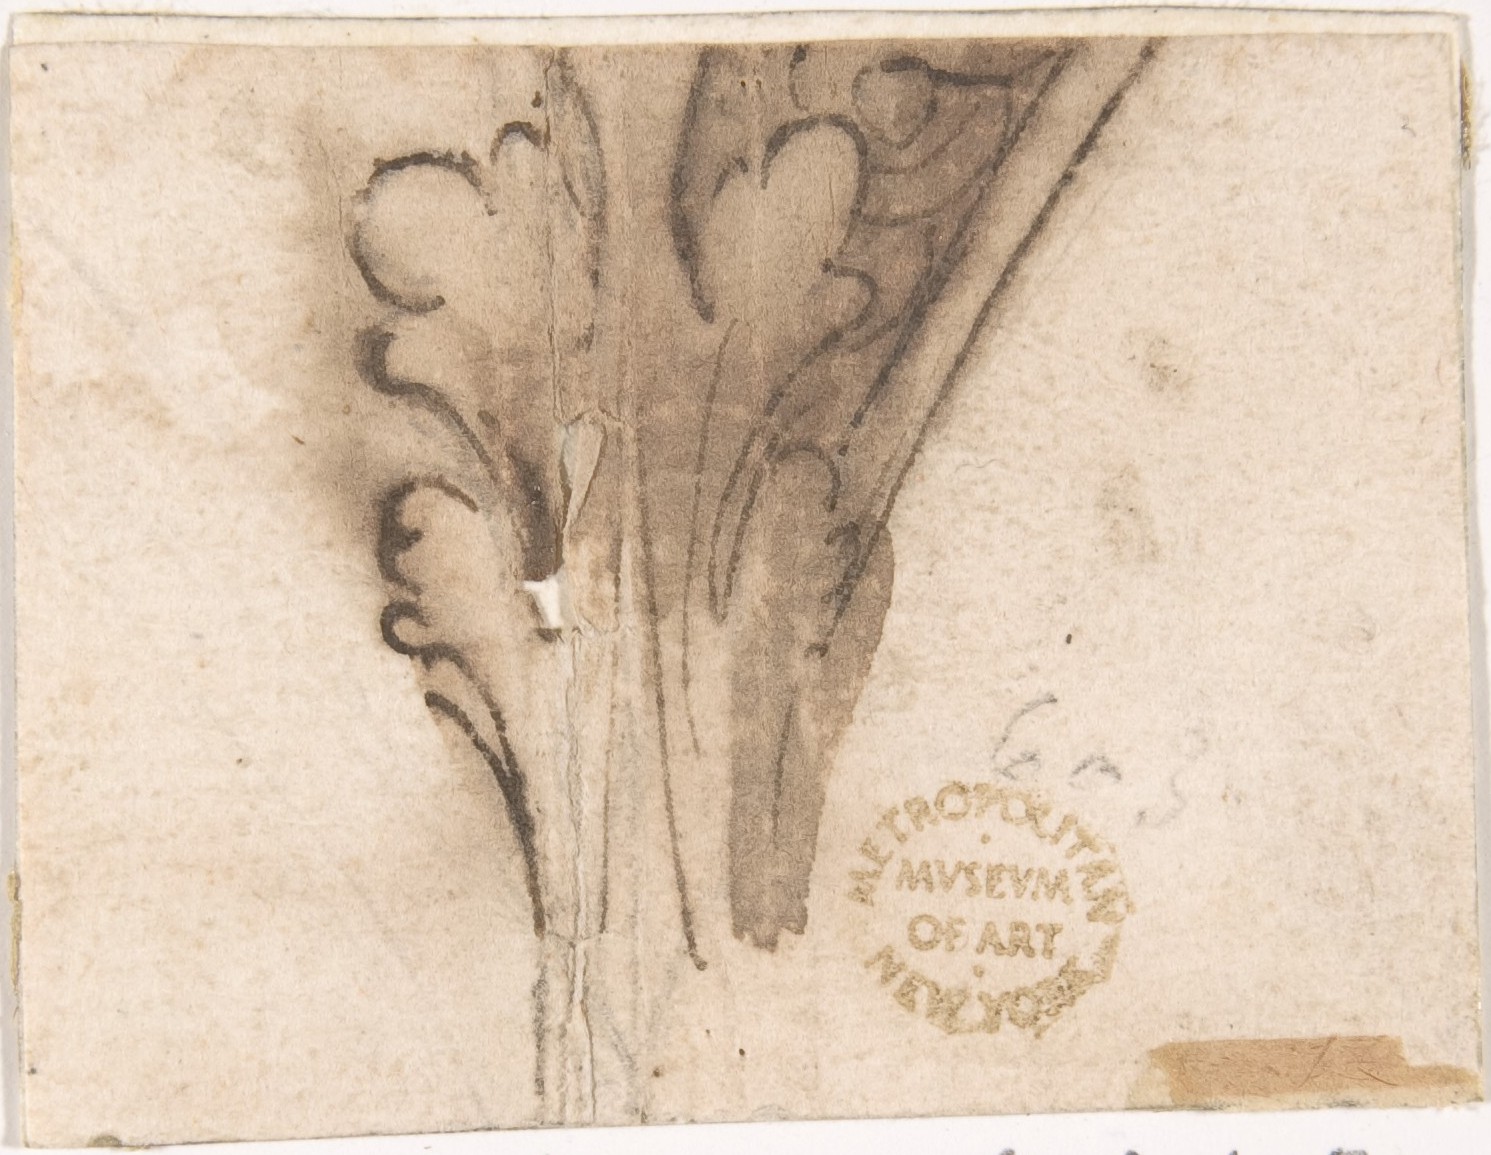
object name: drawing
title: Architectural detail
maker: anonymous, italian, 16th century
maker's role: artist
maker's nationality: italian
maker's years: 1550-1600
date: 1501-1600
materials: ink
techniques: pen, wash